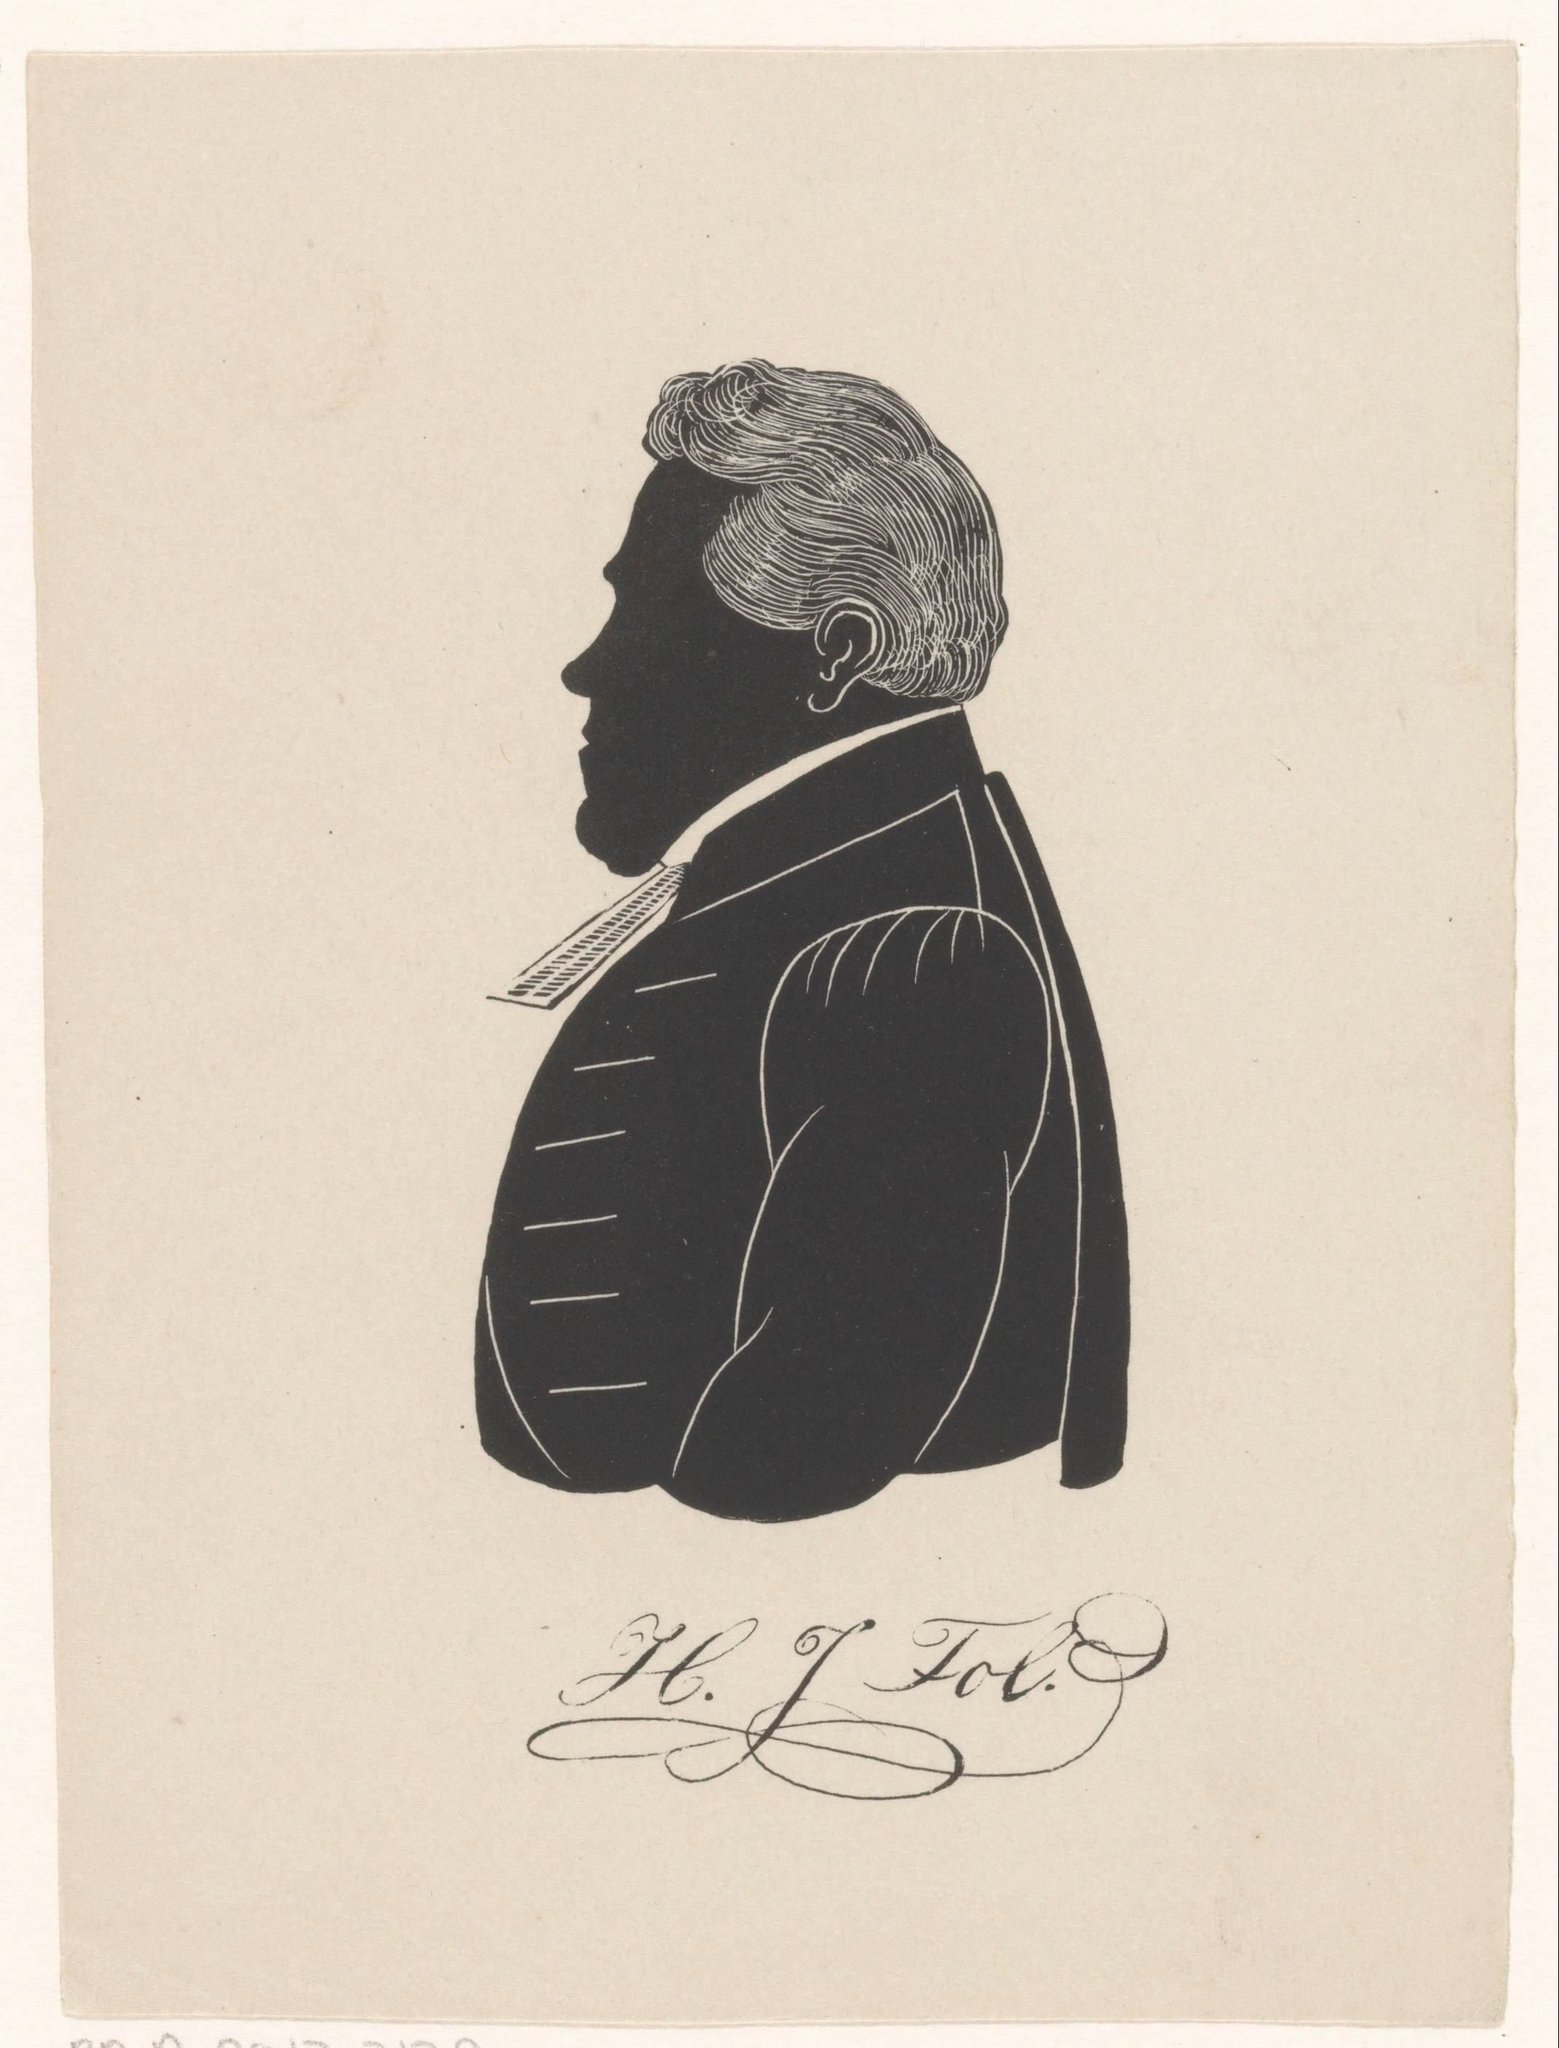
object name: print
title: Silhouetportret van Hendrik Jacob Tol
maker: pieter barbiers (iv)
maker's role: painter, print maker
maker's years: 1798-1848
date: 1809-1848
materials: paper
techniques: hand coloring, lithograph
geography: netherlands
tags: historical persons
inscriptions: collector's mark: Lugt 2228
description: Onder het portret de signatuur van de geportretteerde.